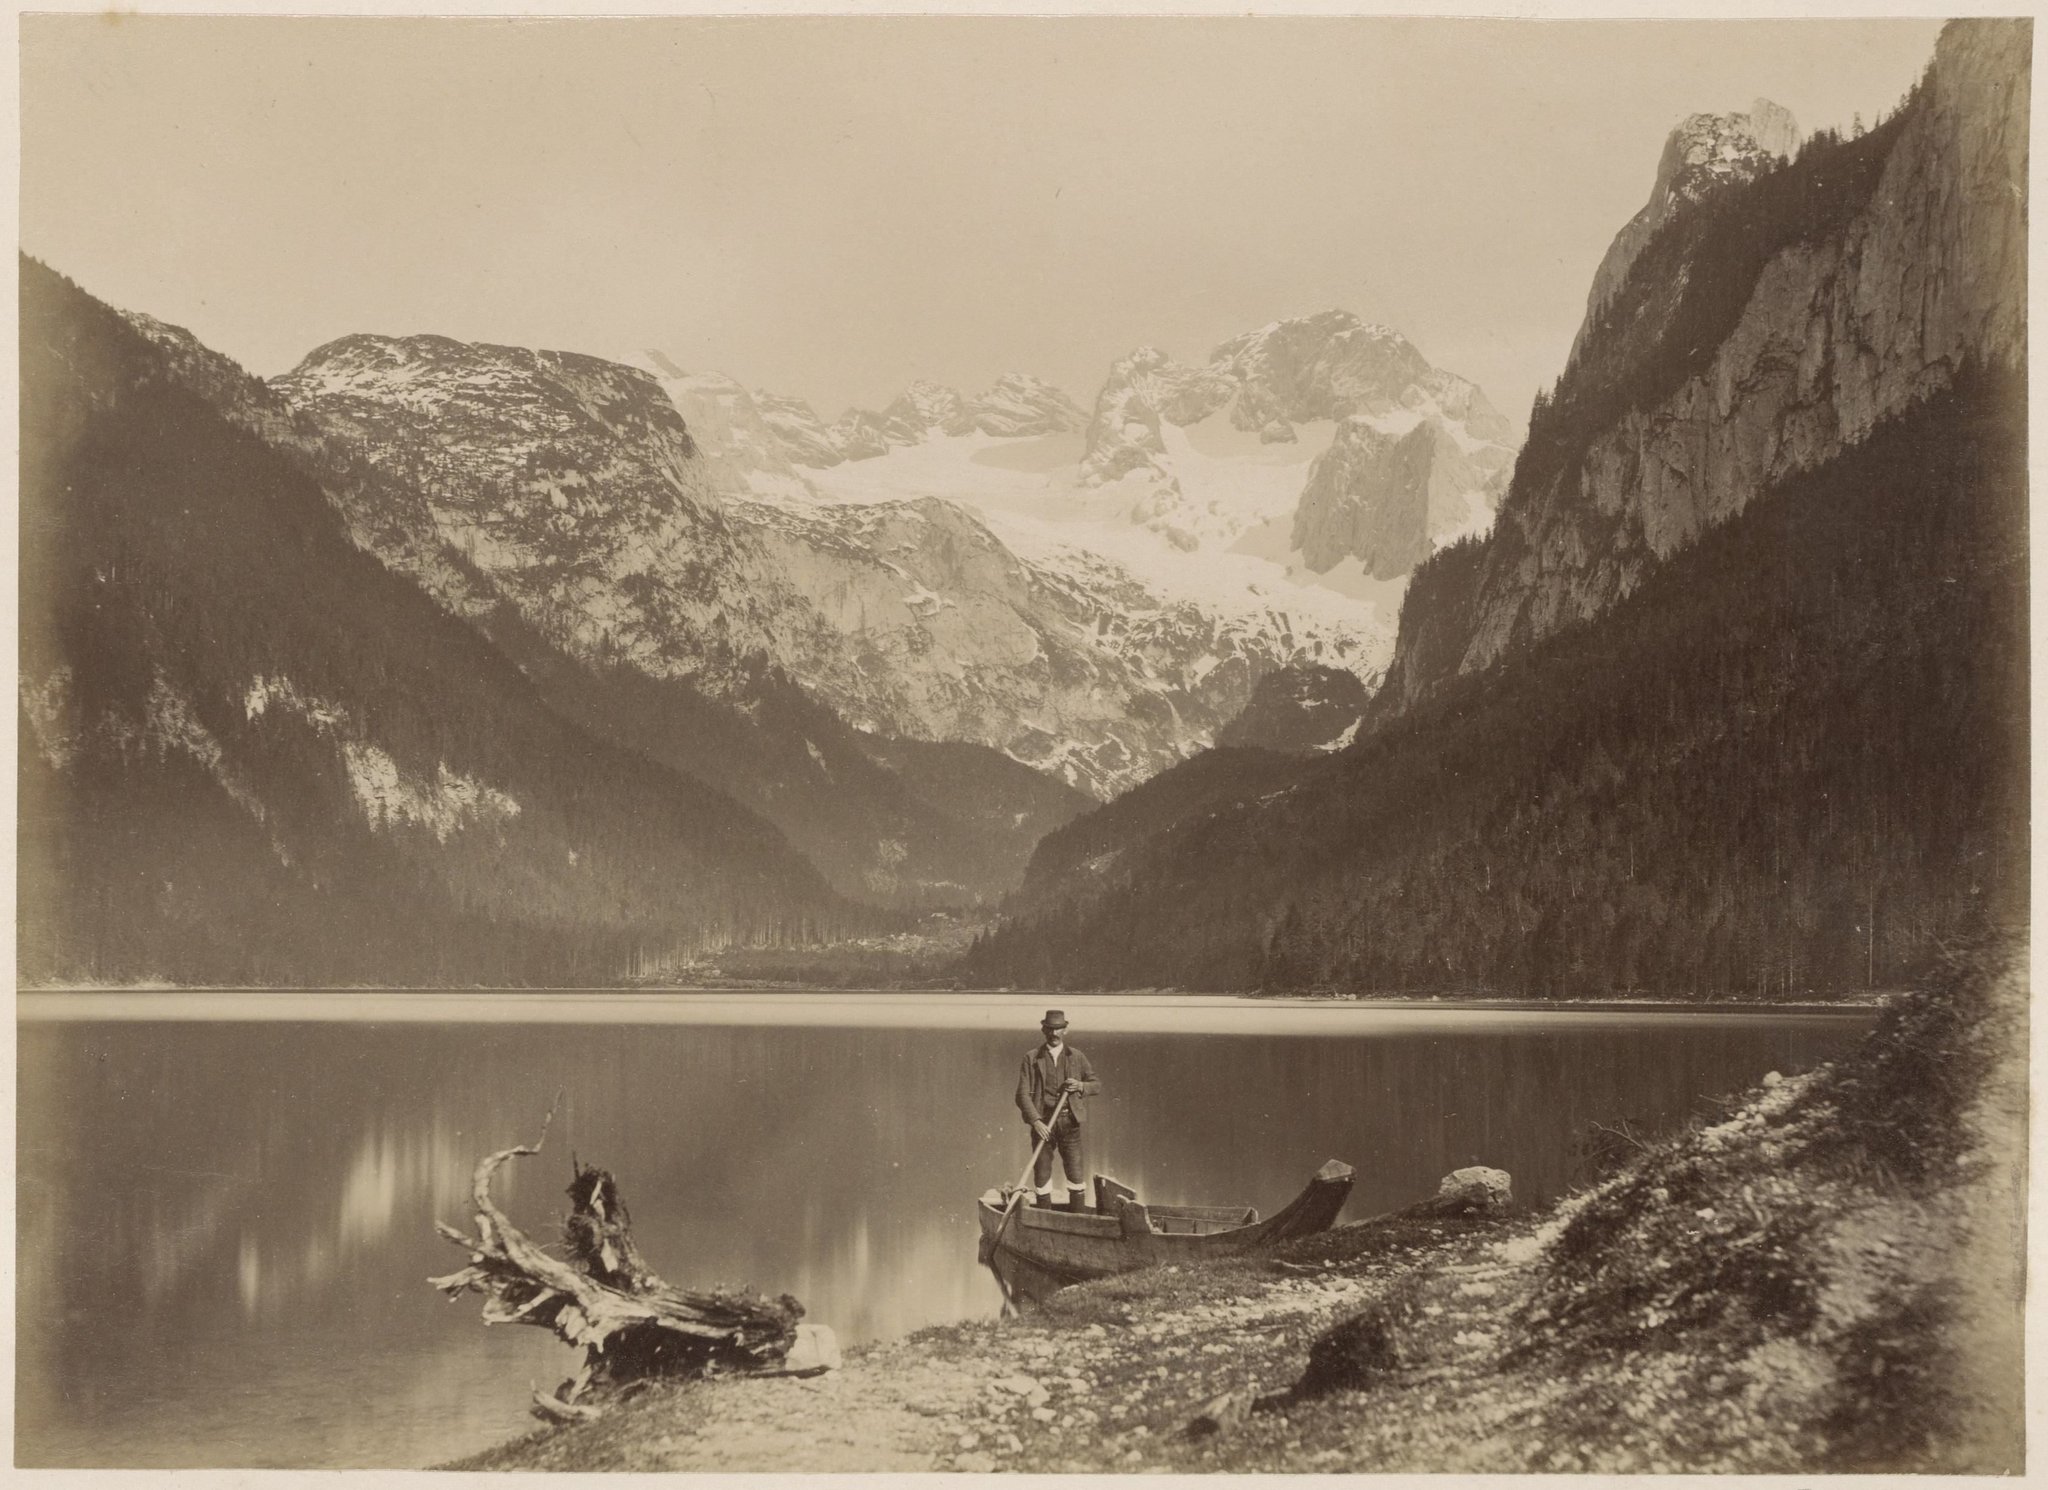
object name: photograph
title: Gezicht op een meer en omliggende bergen met op de voorgrond een man staand in een boot, vermoedelijk in de Alpen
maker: Anonymous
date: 1870-1900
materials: paper, photographic support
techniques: albumen print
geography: alps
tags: mountain-top, peak (+ landscape with figures, staffage)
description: Onderdeel van Reisalbum met foto's van bezienswaardigheden in Duitsland en Oostenrijk en van kunstwerken.